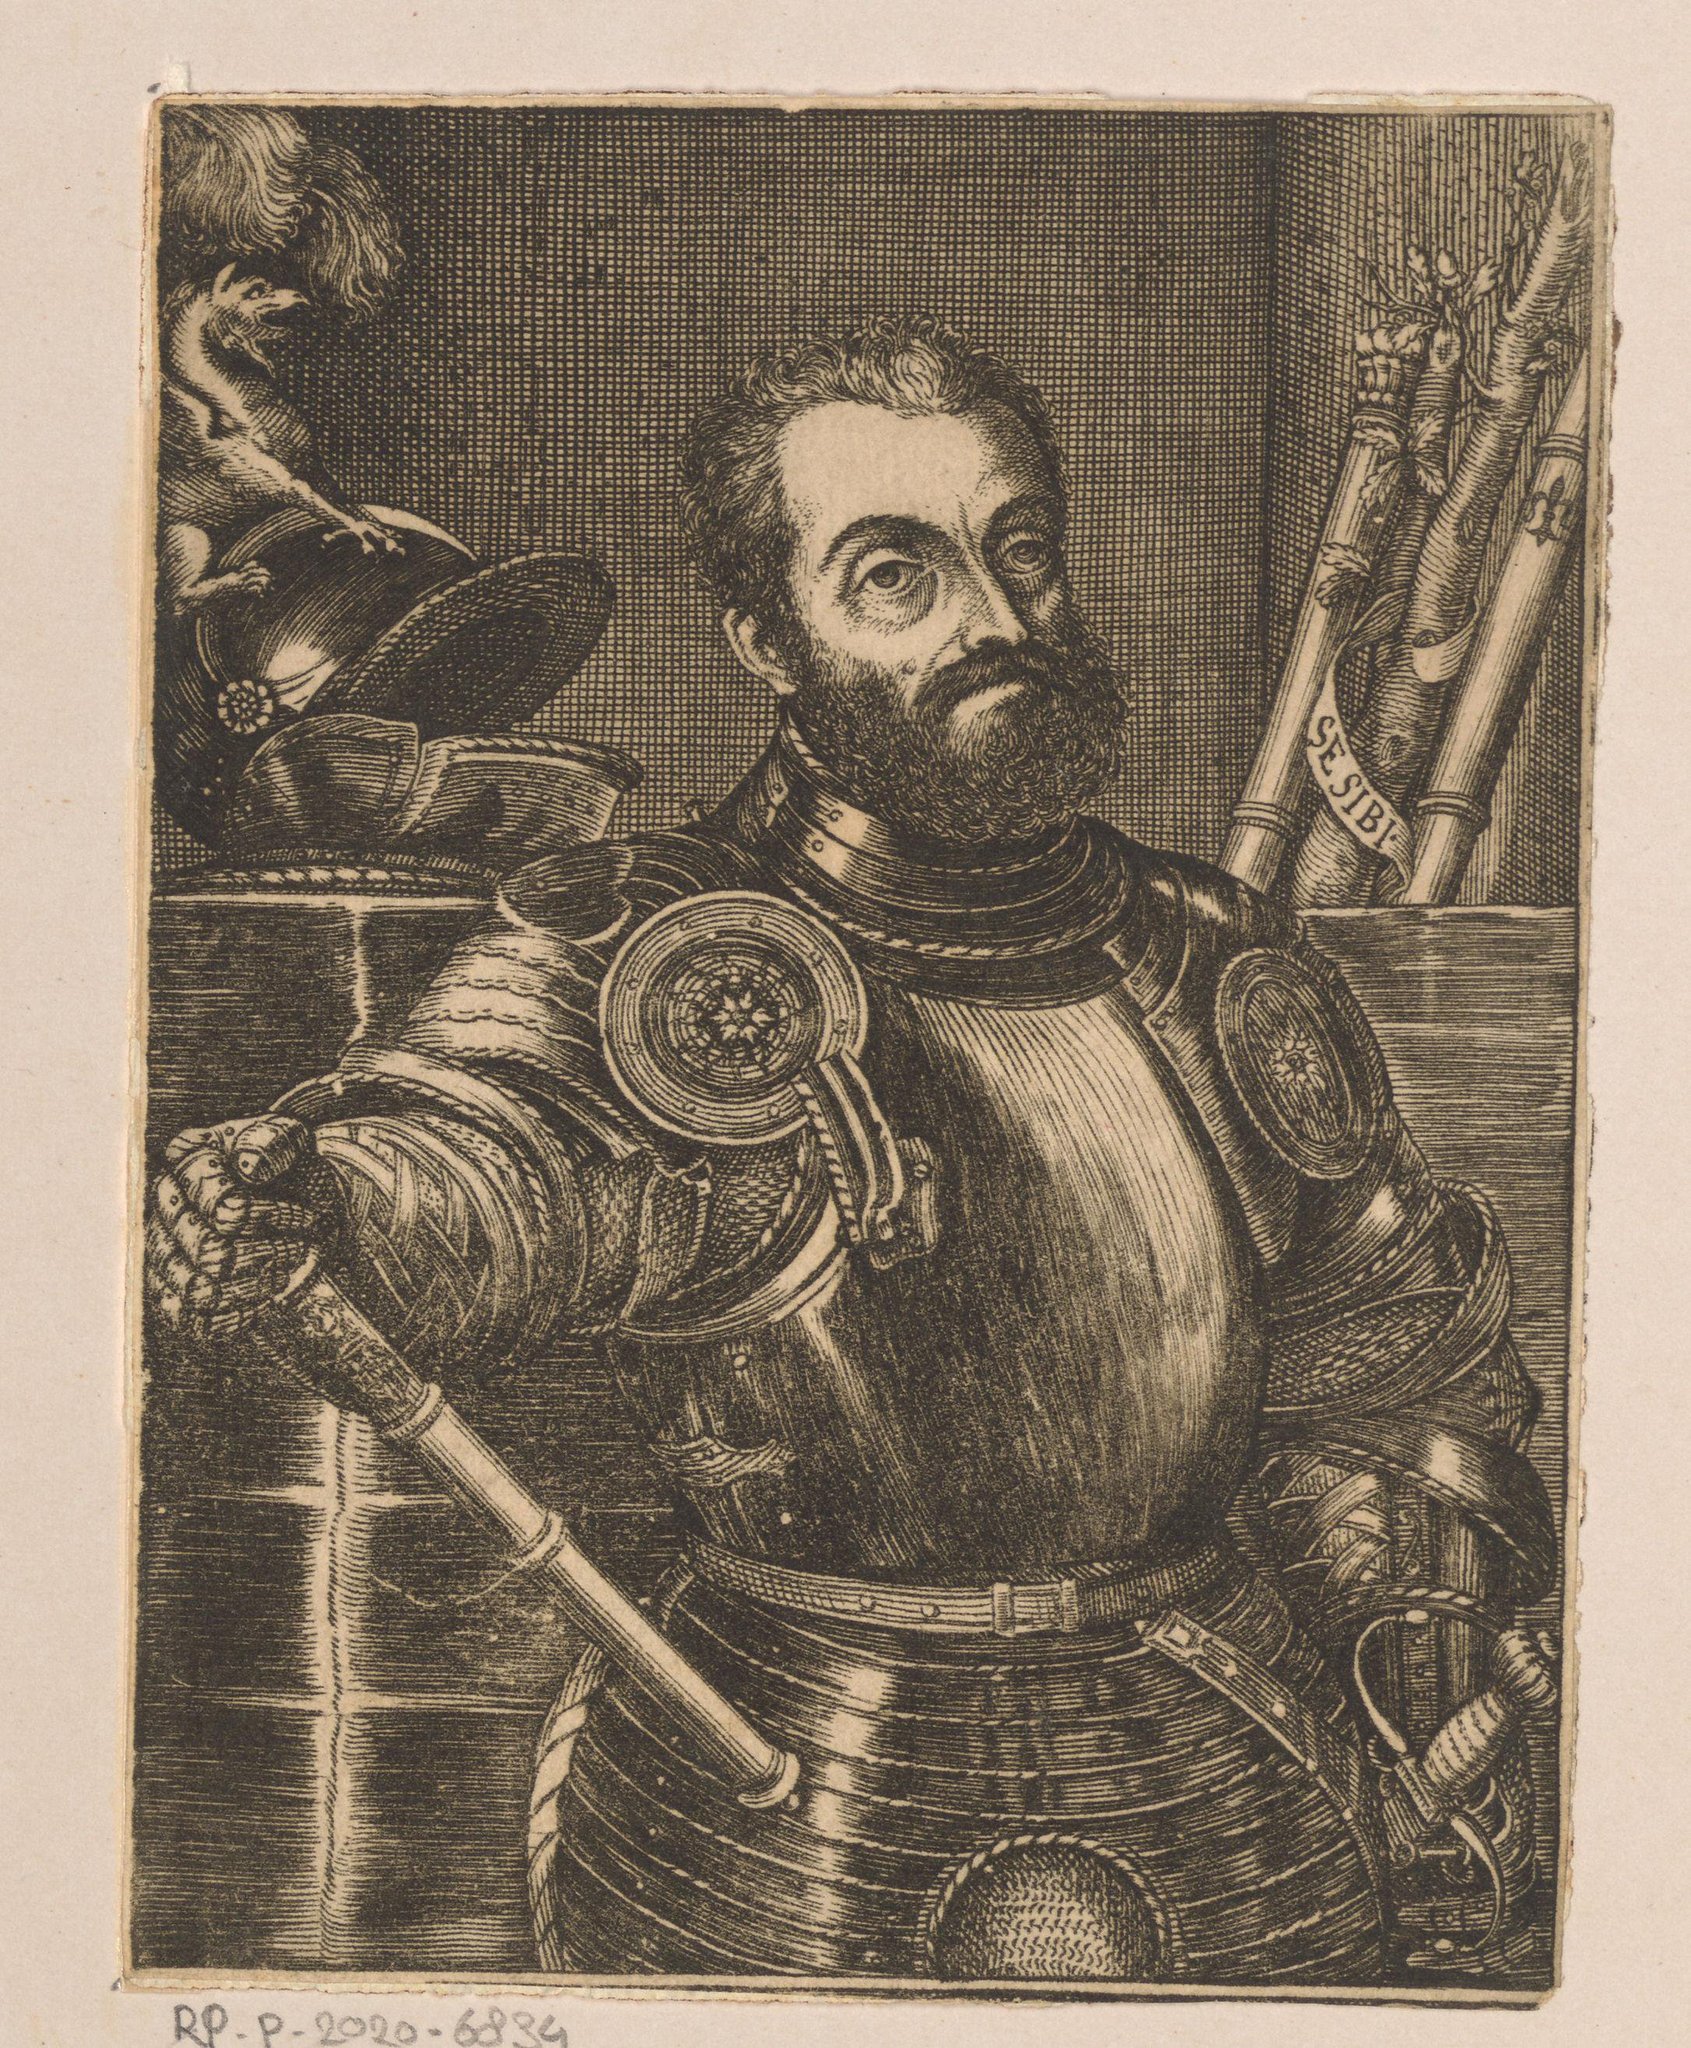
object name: print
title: Portret van keizer Karel V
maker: Anonymous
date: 1600-1699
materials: paper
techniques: etching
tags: ghent, charles v (holy roman emperor and king of spain), harness, historical persons, knighthood order of the golden fleece, king